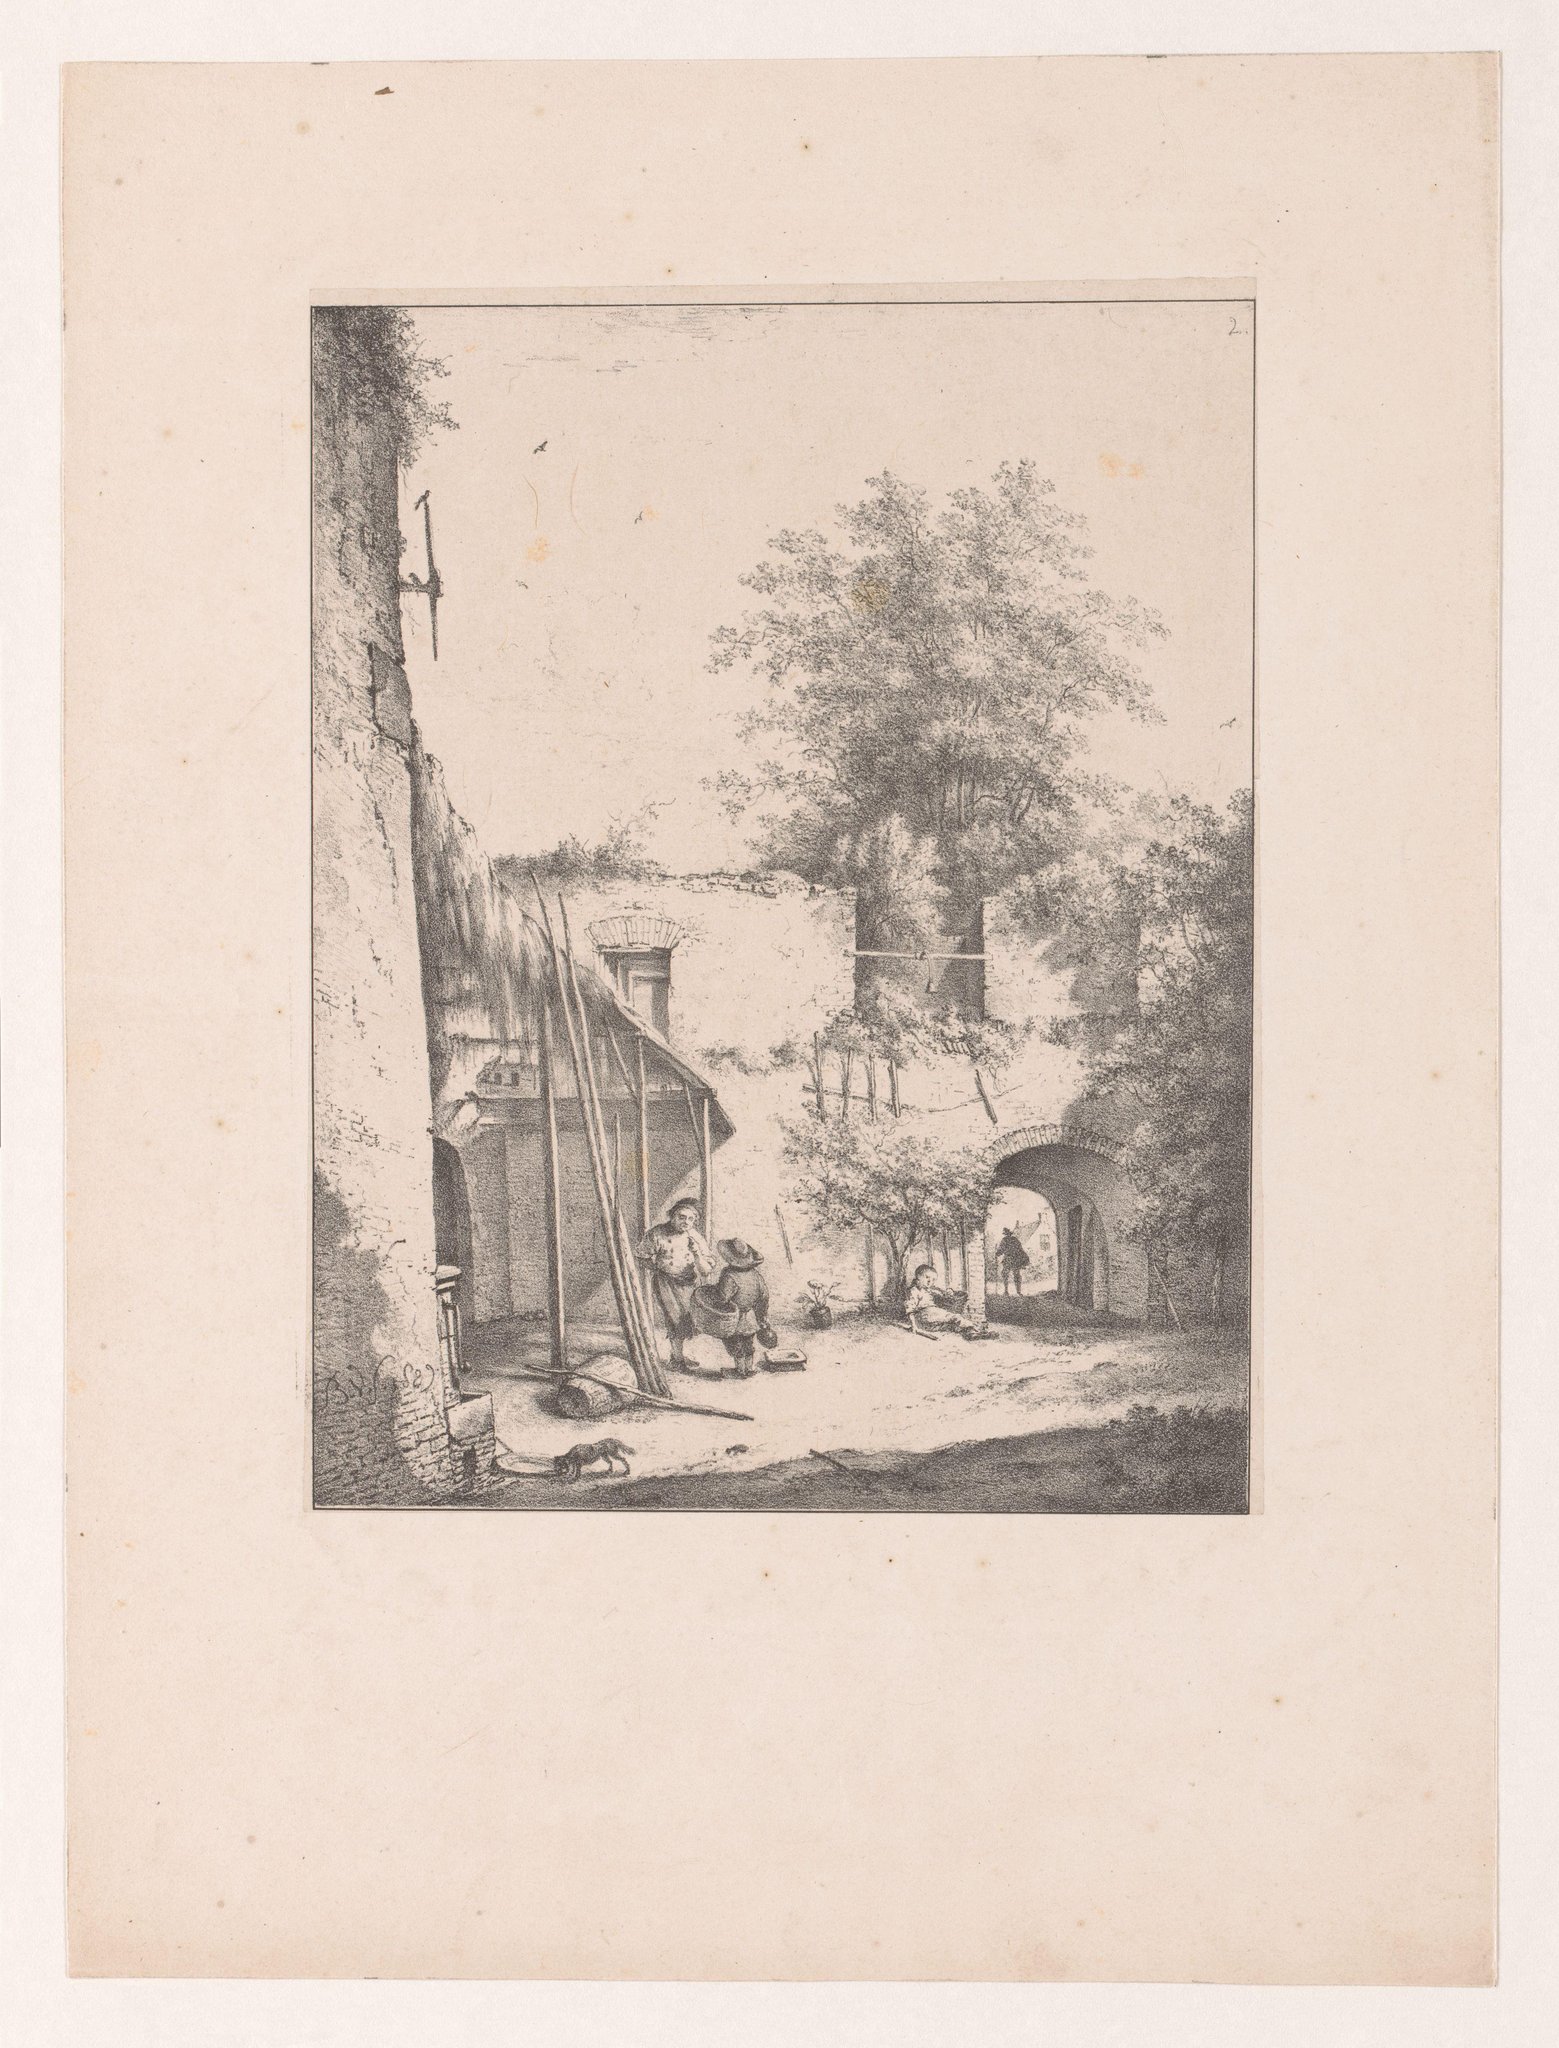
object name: print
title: Landschappen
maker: bruno van straaten (i)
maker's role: draughtsman, print maker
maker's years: 1786-1870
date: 1859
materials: paper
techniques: lithograph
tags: ruin of a dwelling, house, castle, etc.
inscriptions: collector's mark: Lugt 2228, collector's mark: Lugt 2760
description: Binnenplaats van een kasteel met poortgebouw dat dienst doet als boerenbedrijf. Links twee figuren. Bij een stenen ommuring overwoekerd met bomen speelt een kind. Rechts onder een poort loopt een figuur met wandelstok.